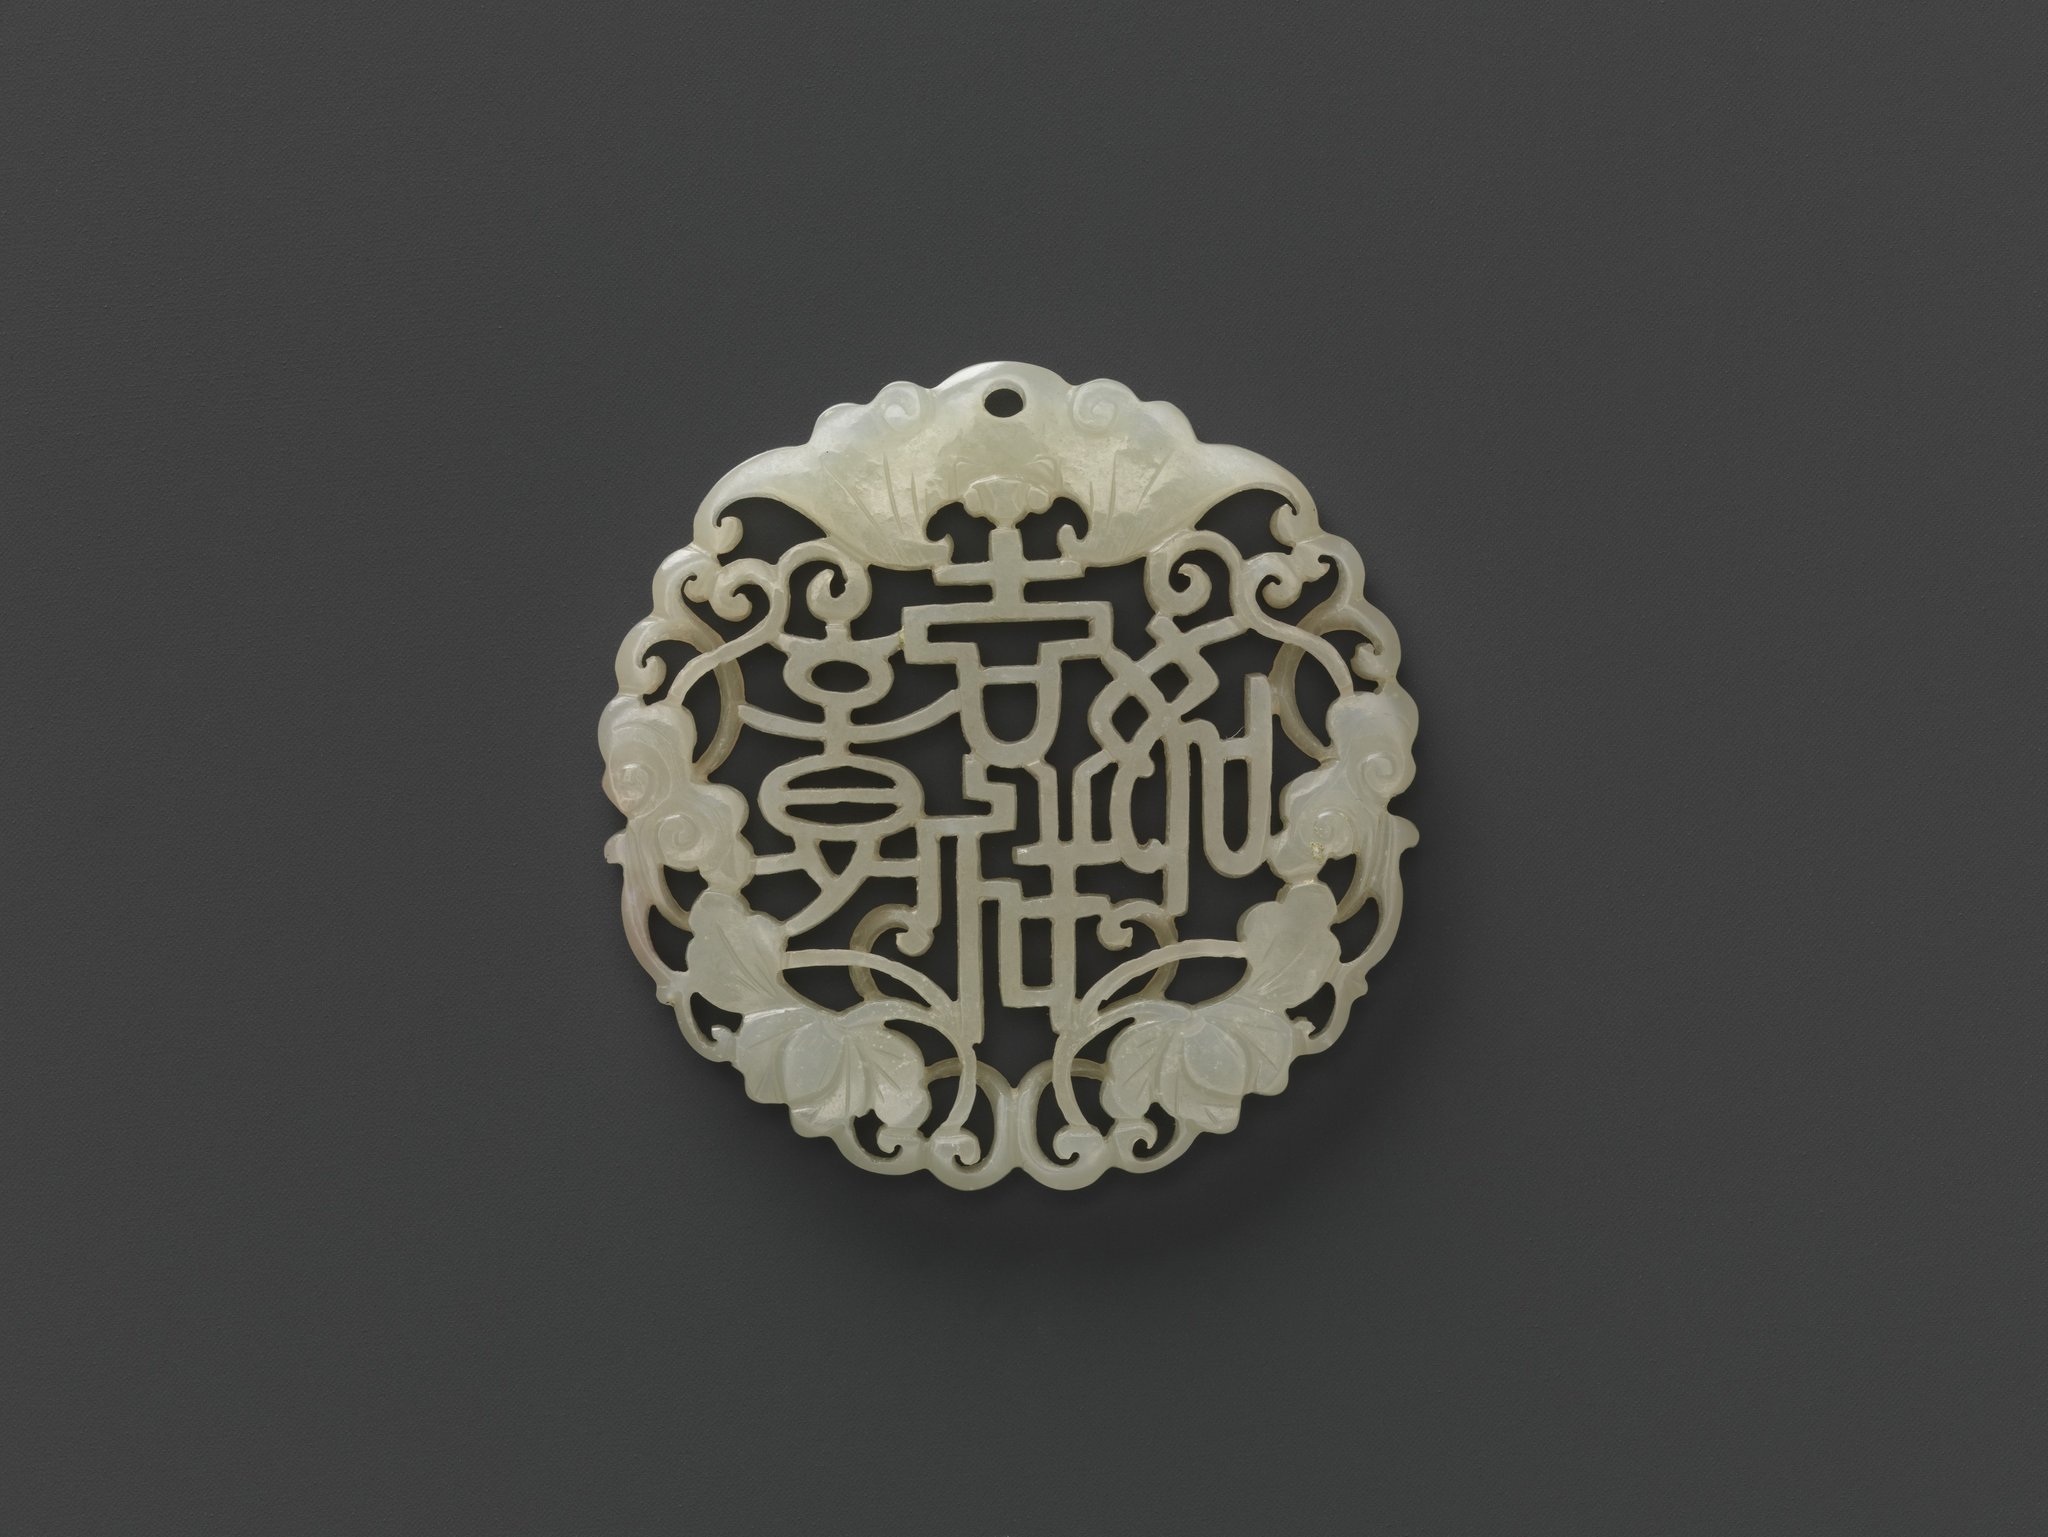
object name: pendant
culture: chinese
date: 1701-1900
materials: jade